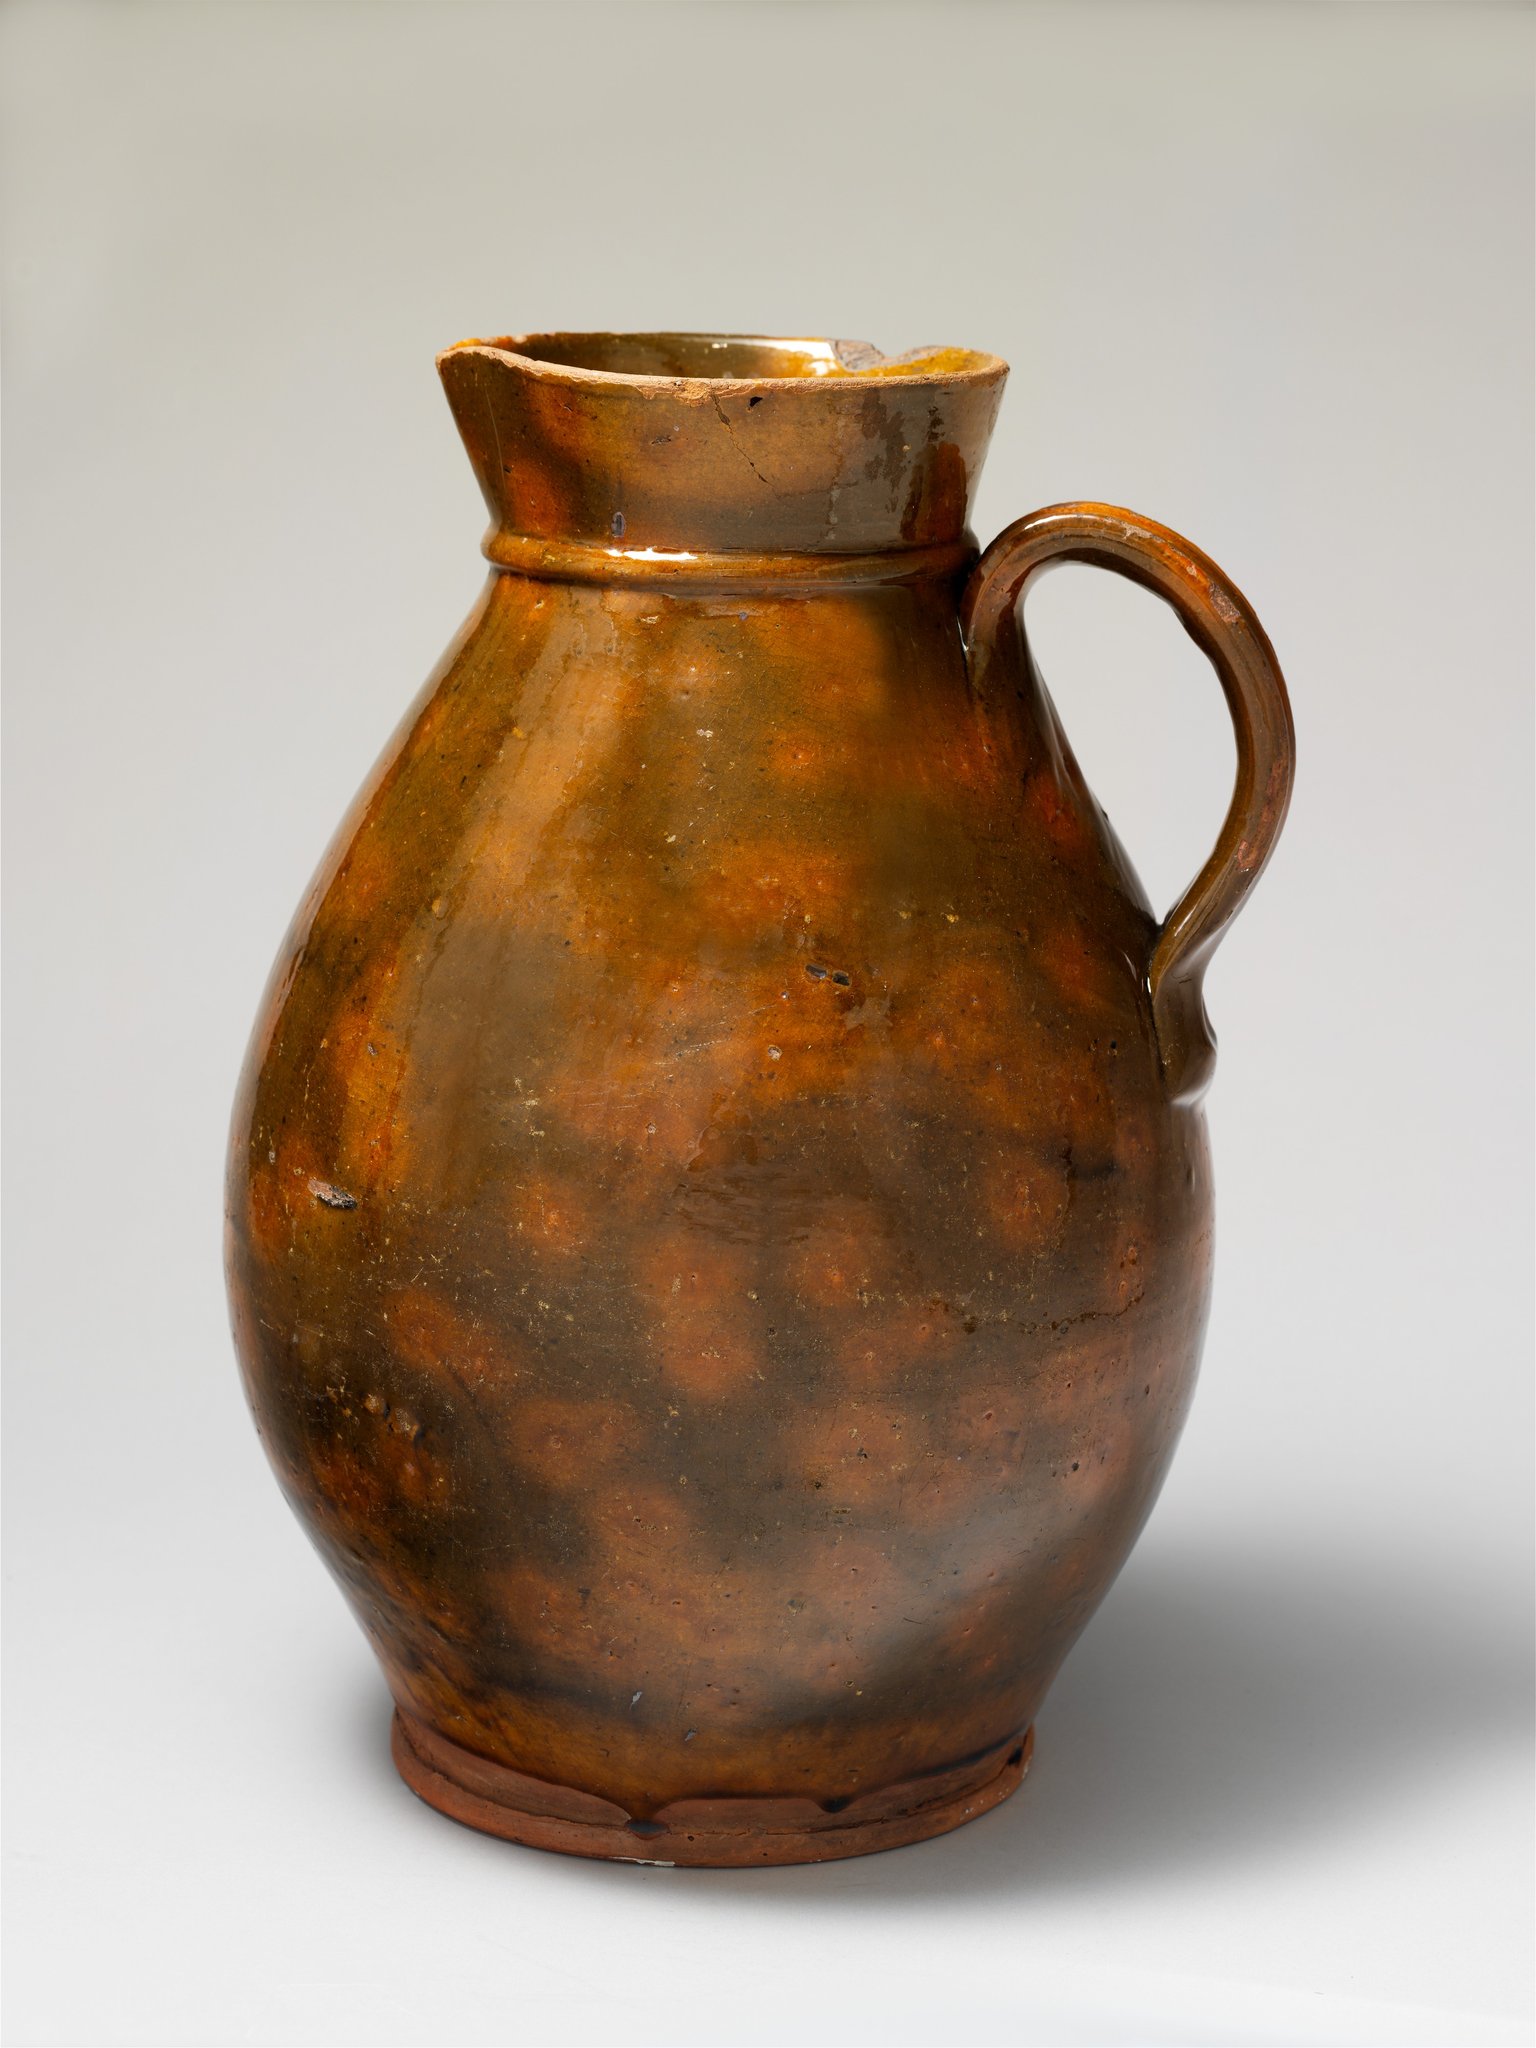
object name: pitcher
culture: american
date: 1815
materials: earthenware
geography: united states